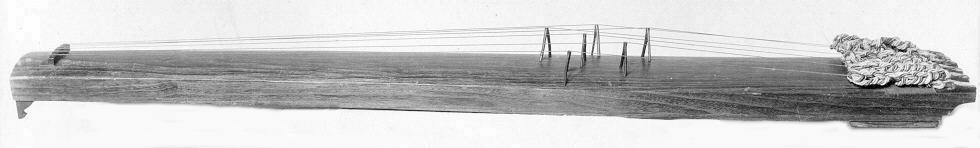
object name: wagon 和琴 yamatogoto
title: Wagon (和琴)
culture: japanese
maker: mizutani kakumu (professional name: fujiwara mitsukazu or kowa)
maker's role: maker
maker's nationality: japanese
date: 1804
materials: cotton, metal, silk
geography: japan